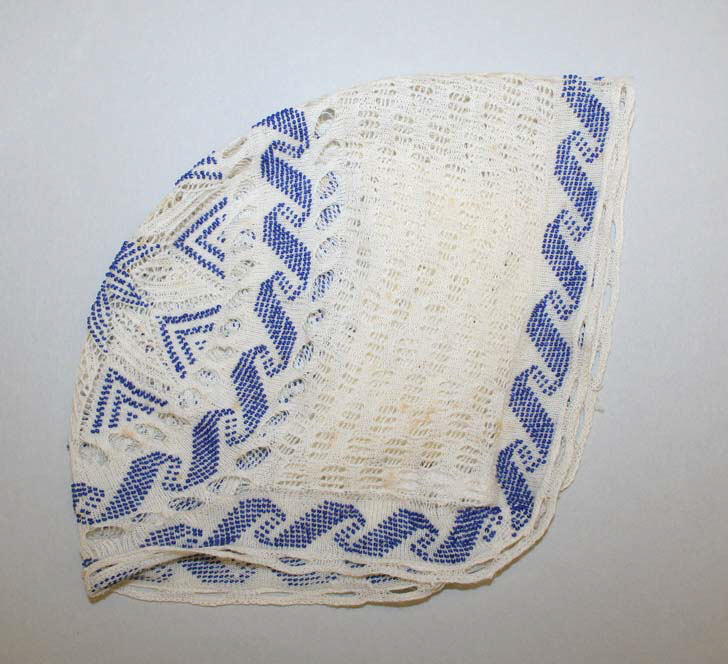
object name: christening cap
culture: european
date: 1801-1833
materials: cotton, glass